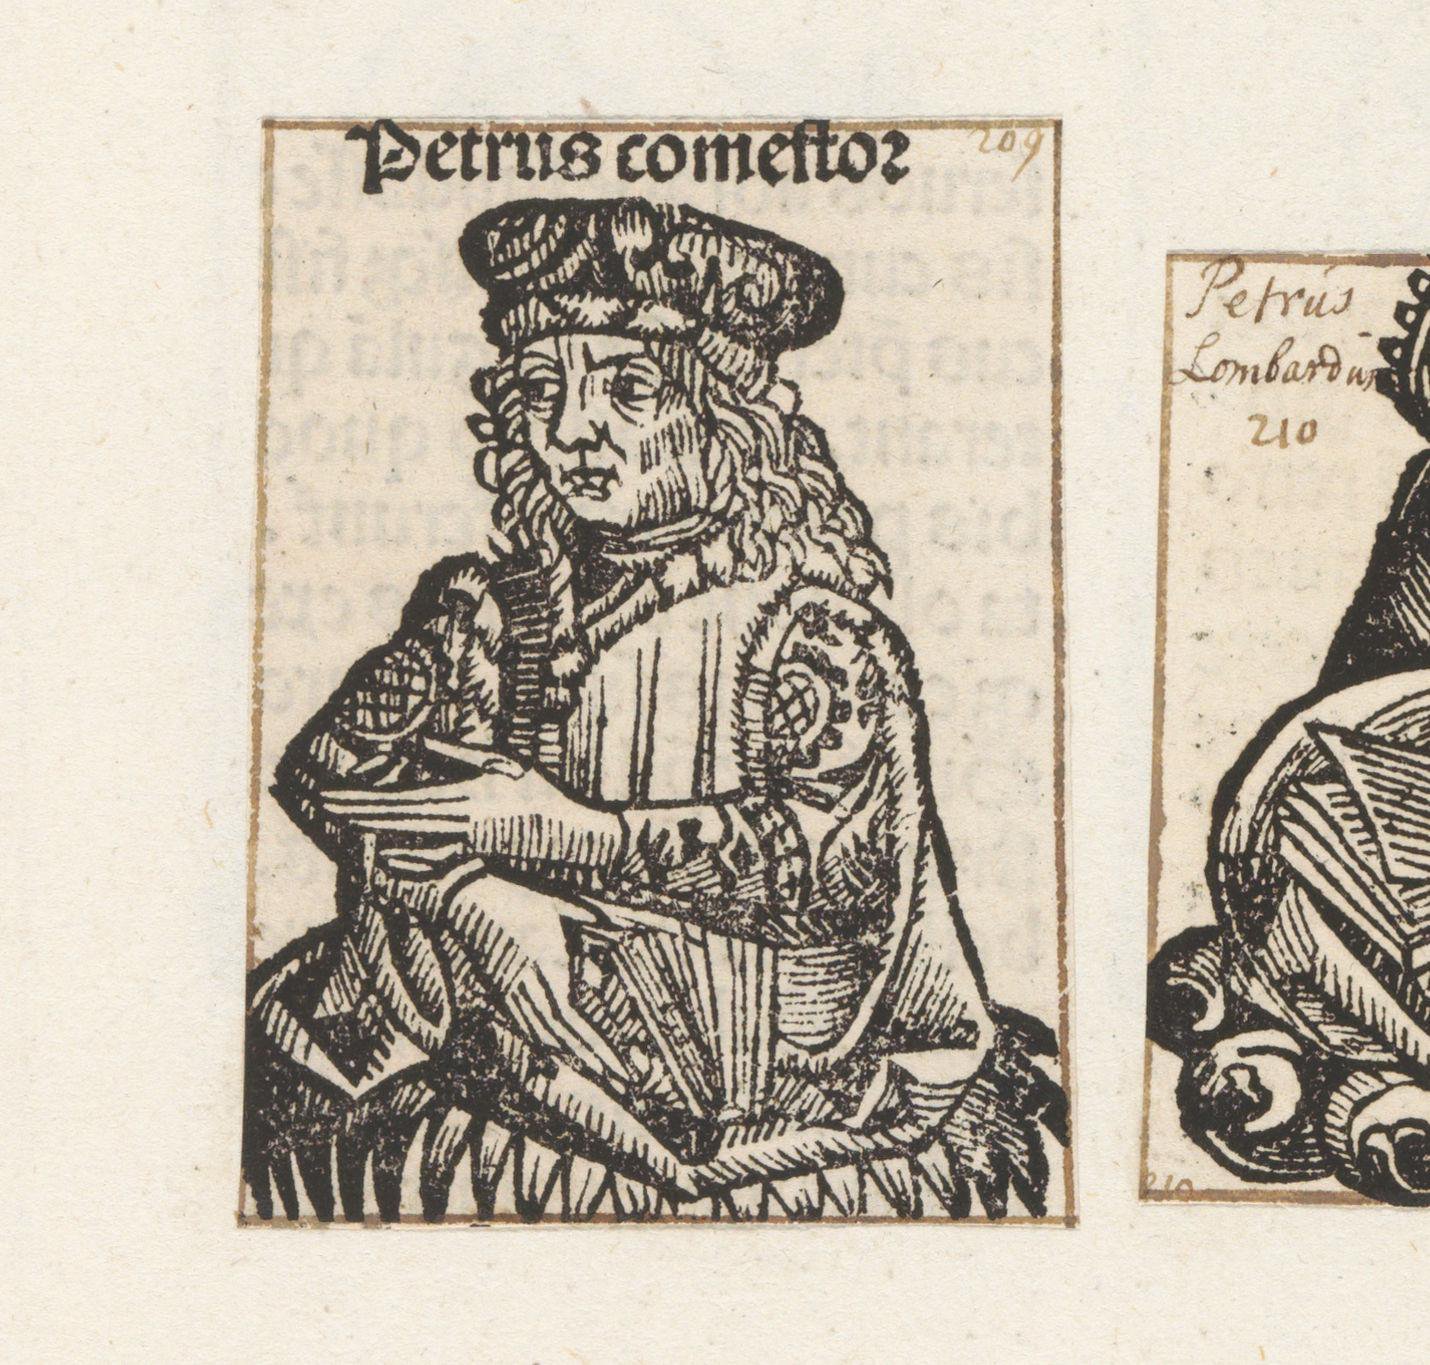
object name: print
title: Petrus Comestor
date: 1493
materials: paper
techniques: letterpress printing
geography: nuremberg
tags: troyes, theoloog, petrus comestor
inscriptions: inscription: ‘209’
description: De houtsnede wordt herhaaldelijk gebruikt als boekillustratie in de Liber Chronicarum (of Neurenbergkroniek) van Hartmann Schedel, verschenen in het Latijn en Duits in 1493. Zie de Latijnse uitgave, folio 201v.